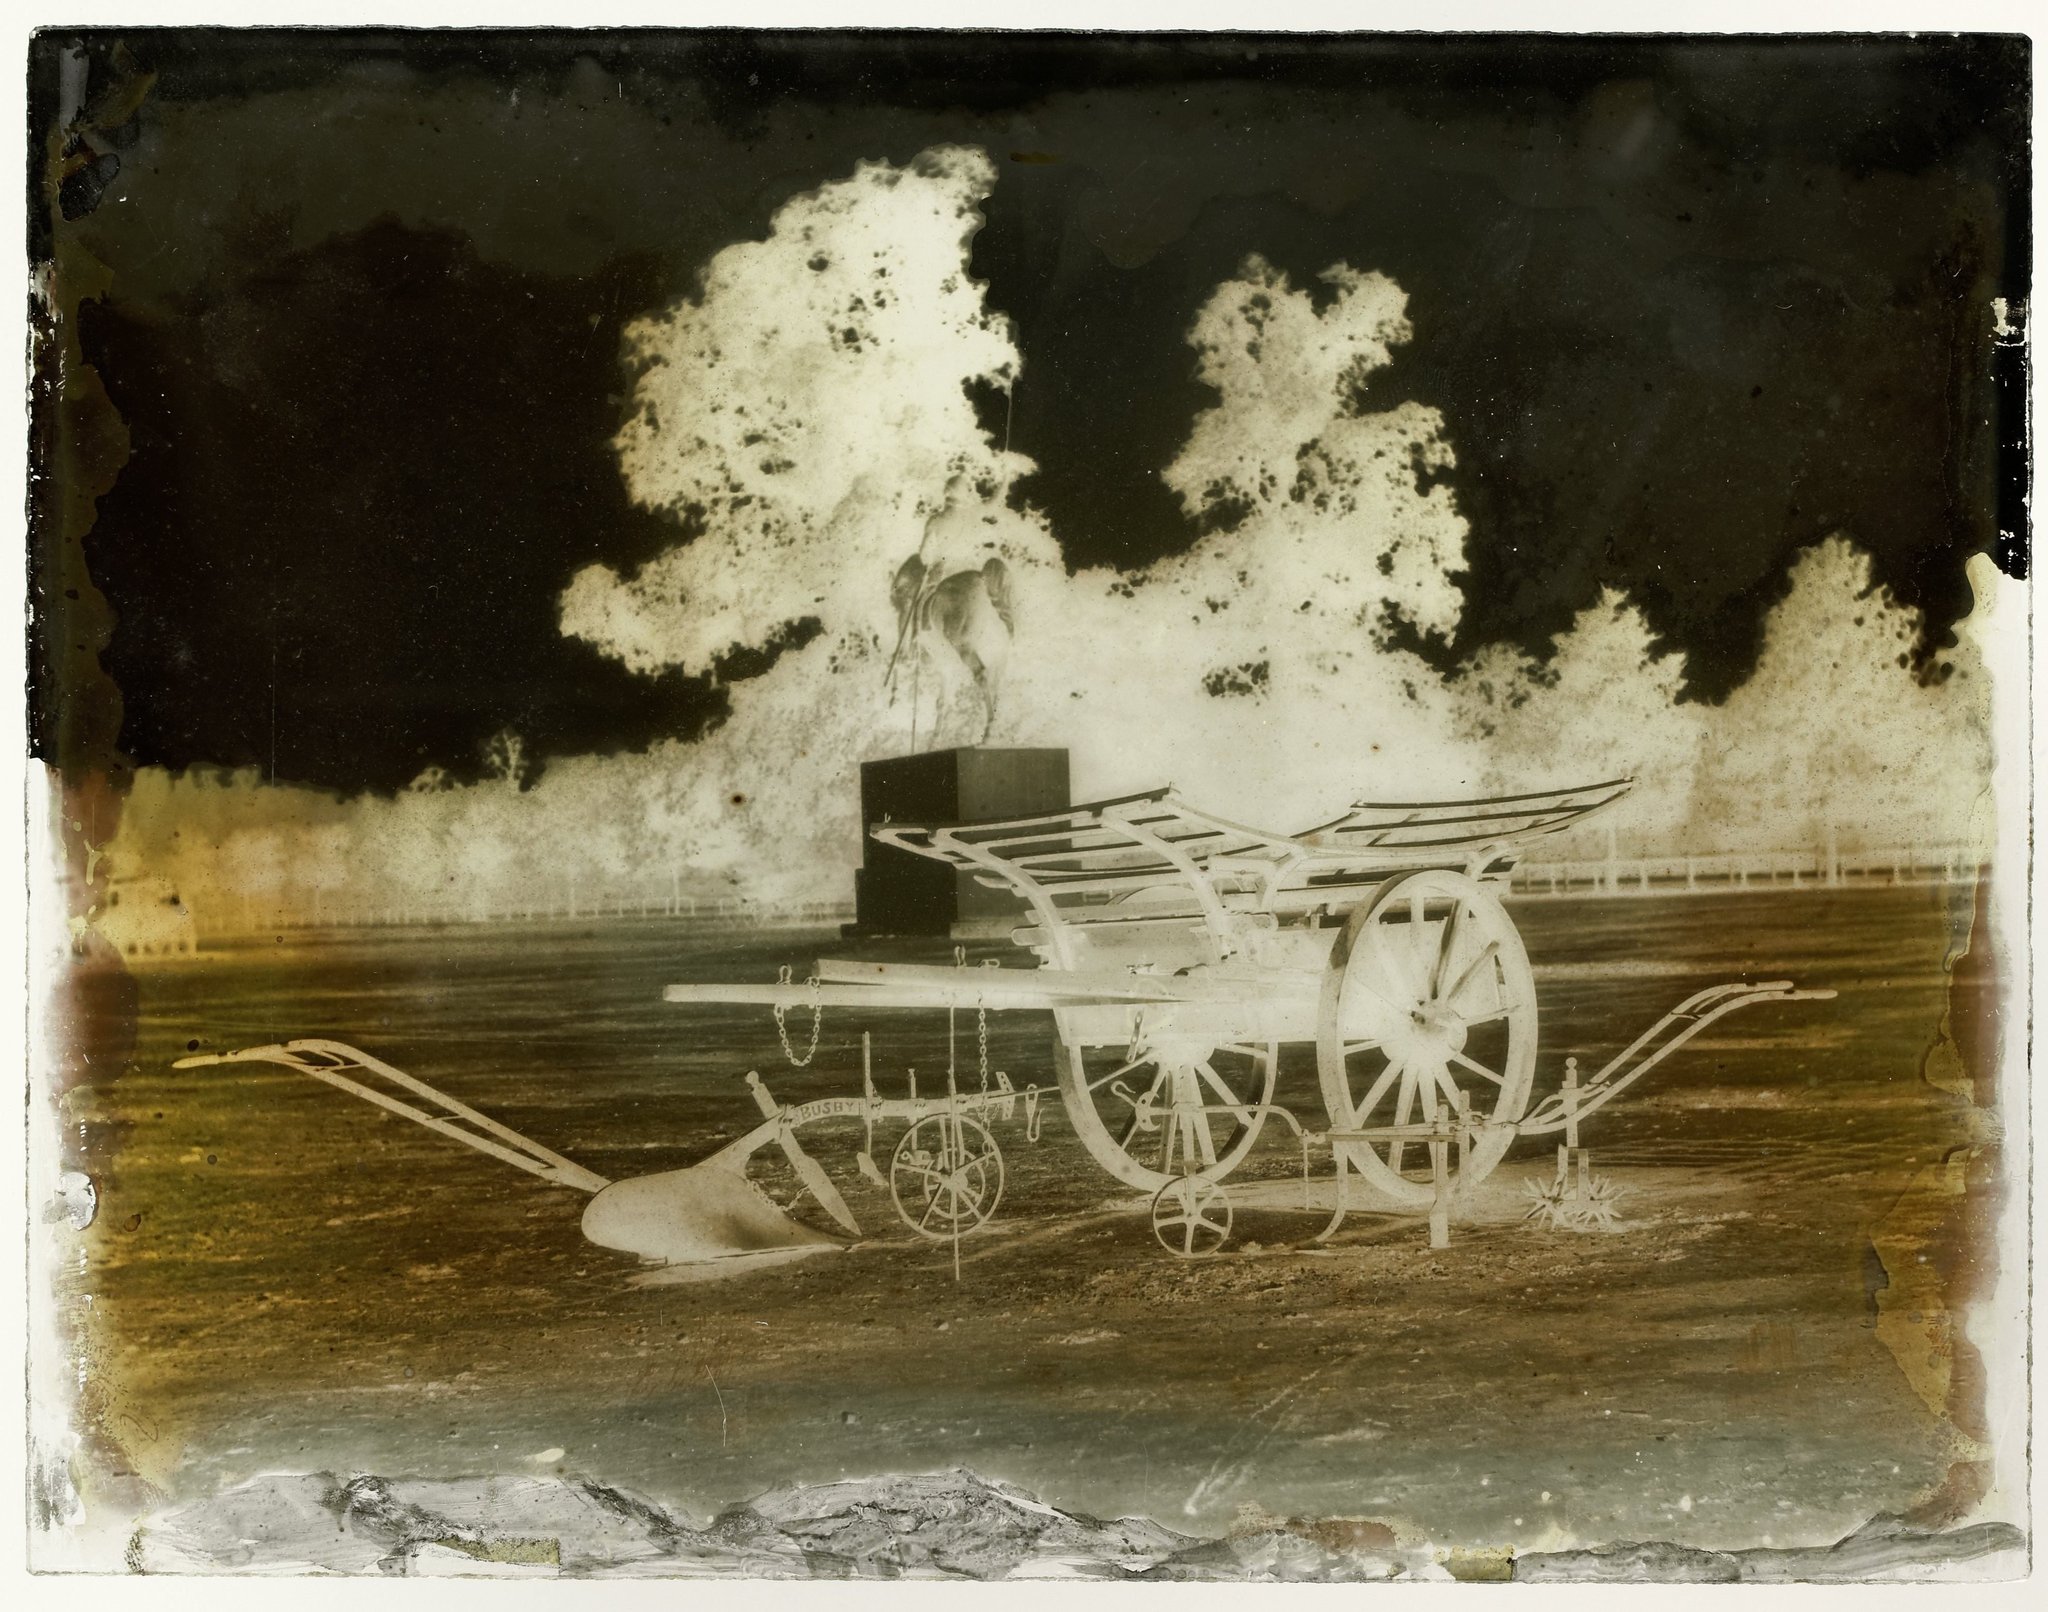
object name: photograph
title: Landbouwinstrumenten, inzending van Busby op de Great Exhibition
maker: claude-marie ferrier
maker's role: fotograaf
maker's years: 1811-1889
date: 1851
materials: glass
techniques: albumen print, hand coloring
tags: agricultural implements